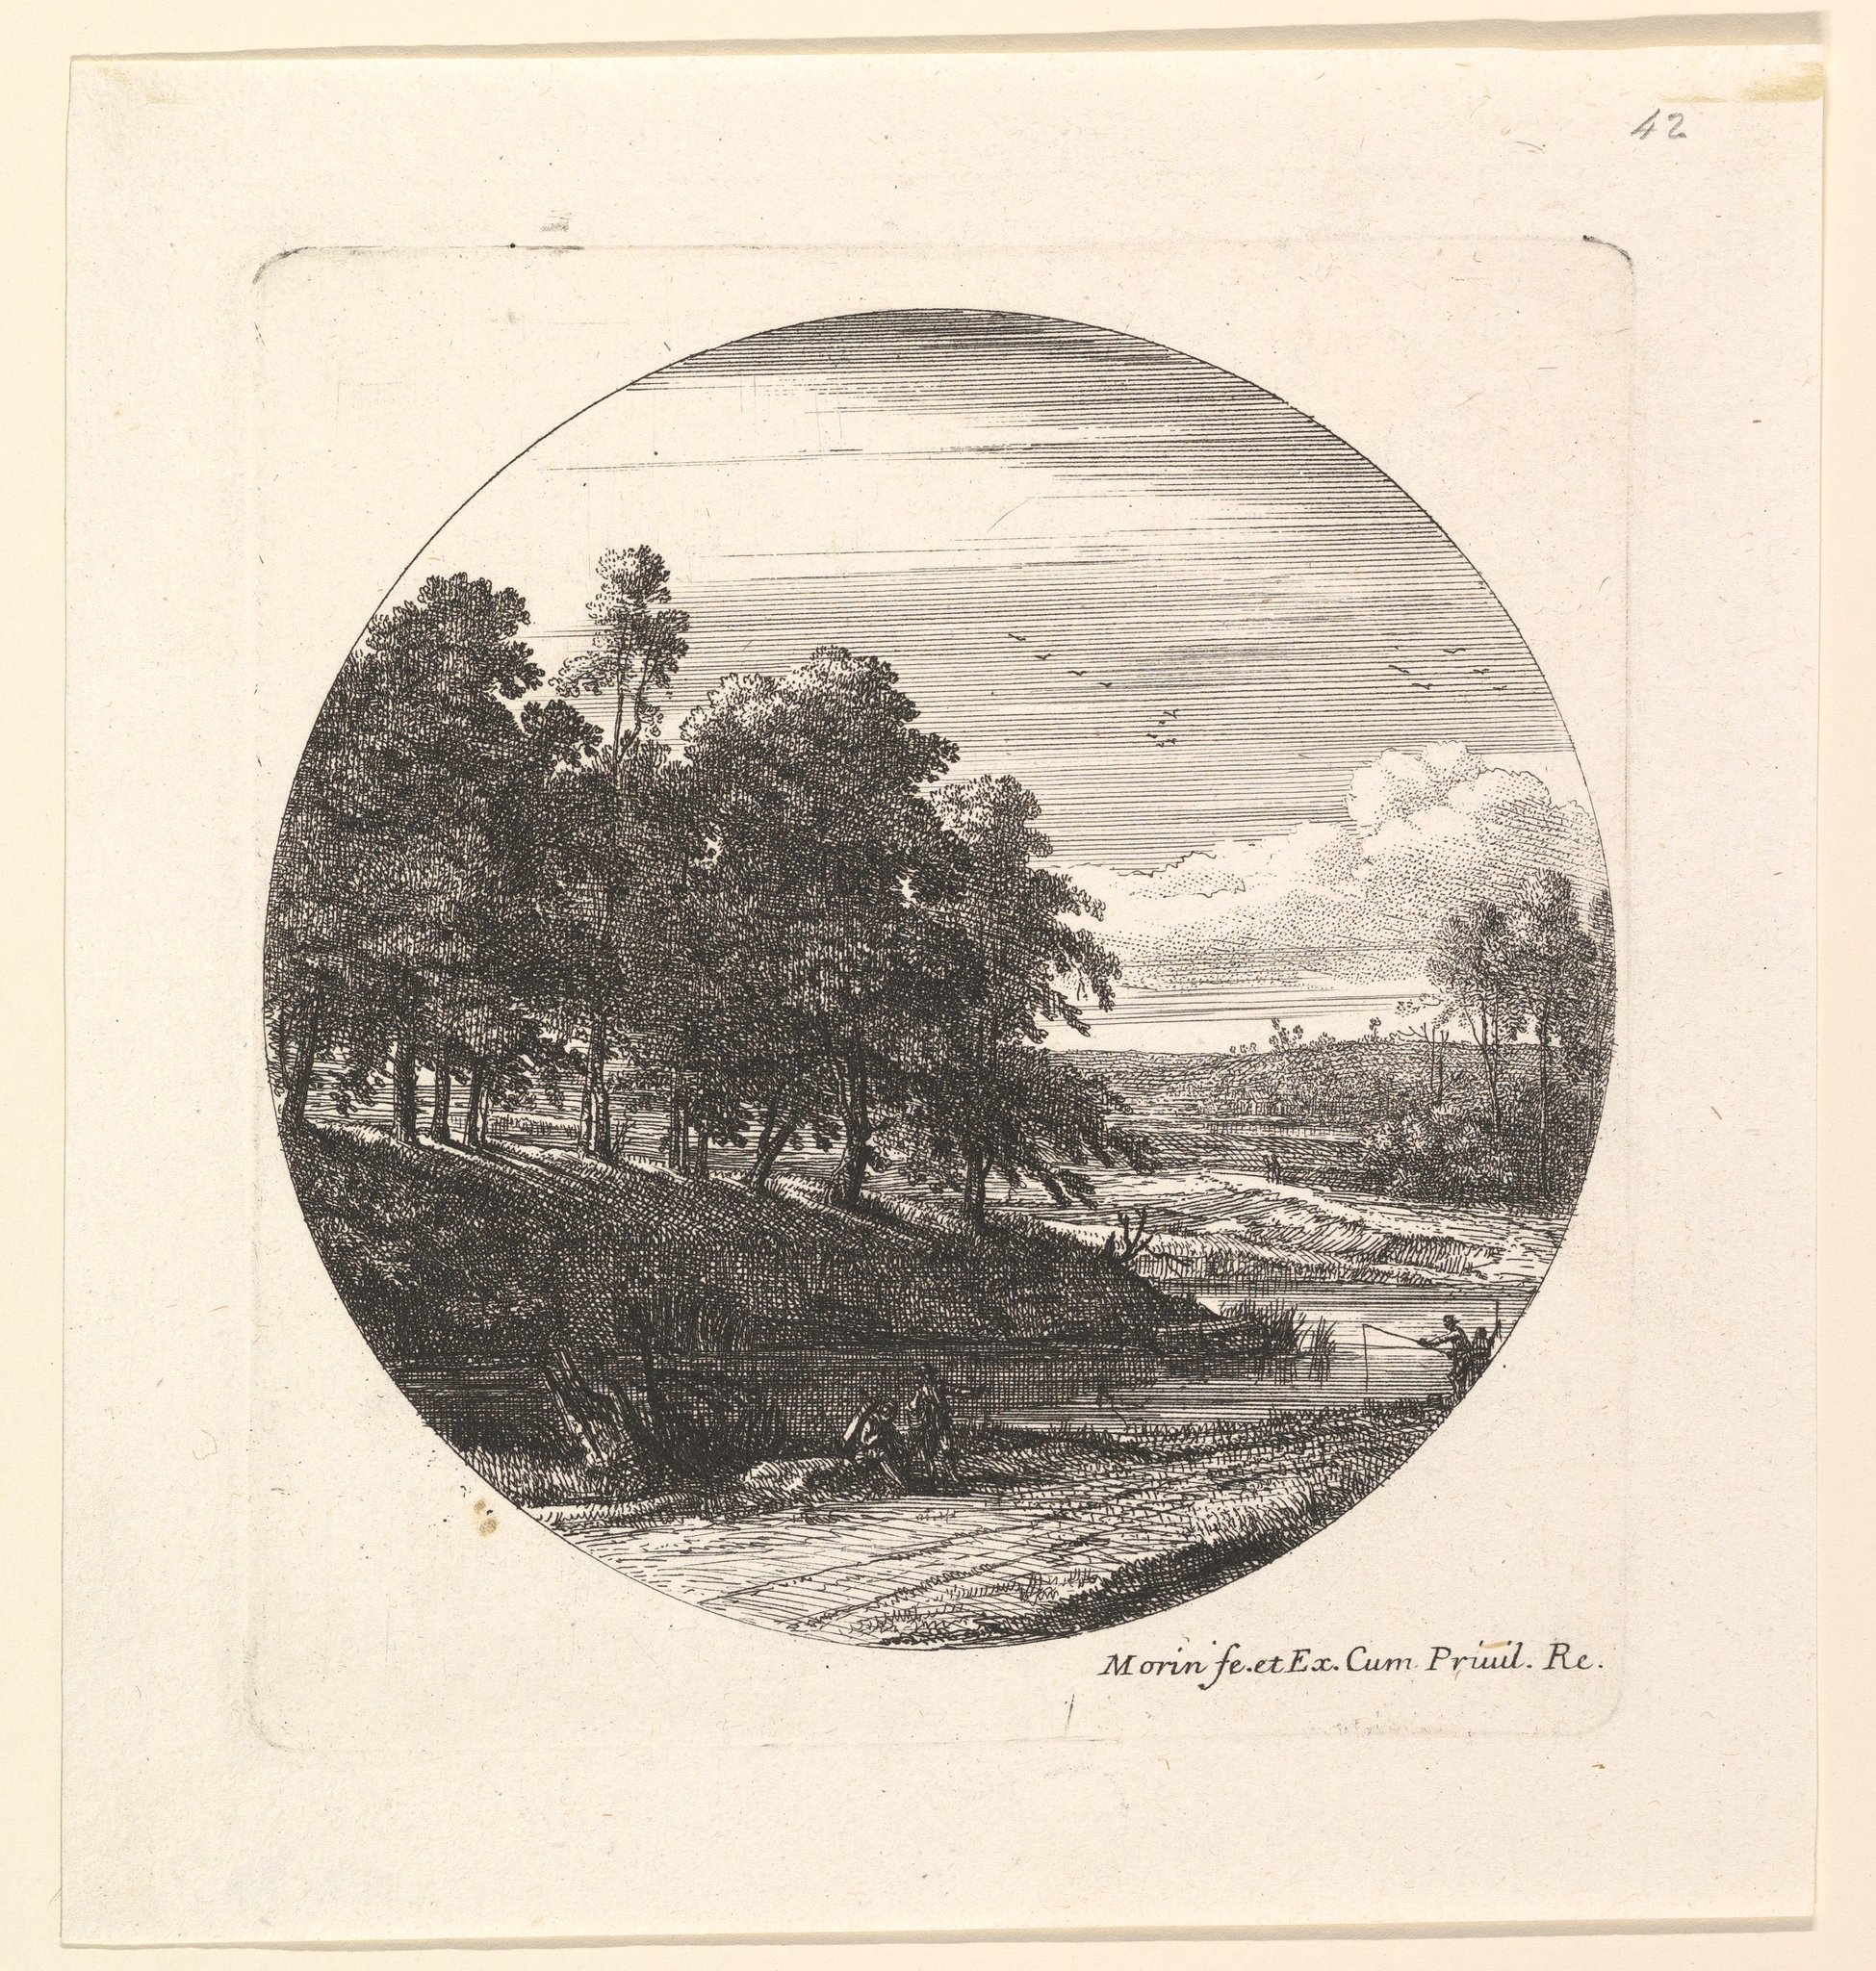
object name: print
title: L'Enclos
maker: jean morin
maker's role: artist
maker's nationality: french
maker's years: 1605-1650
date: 1605-1650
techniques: etching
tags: men,fishing,landscapes